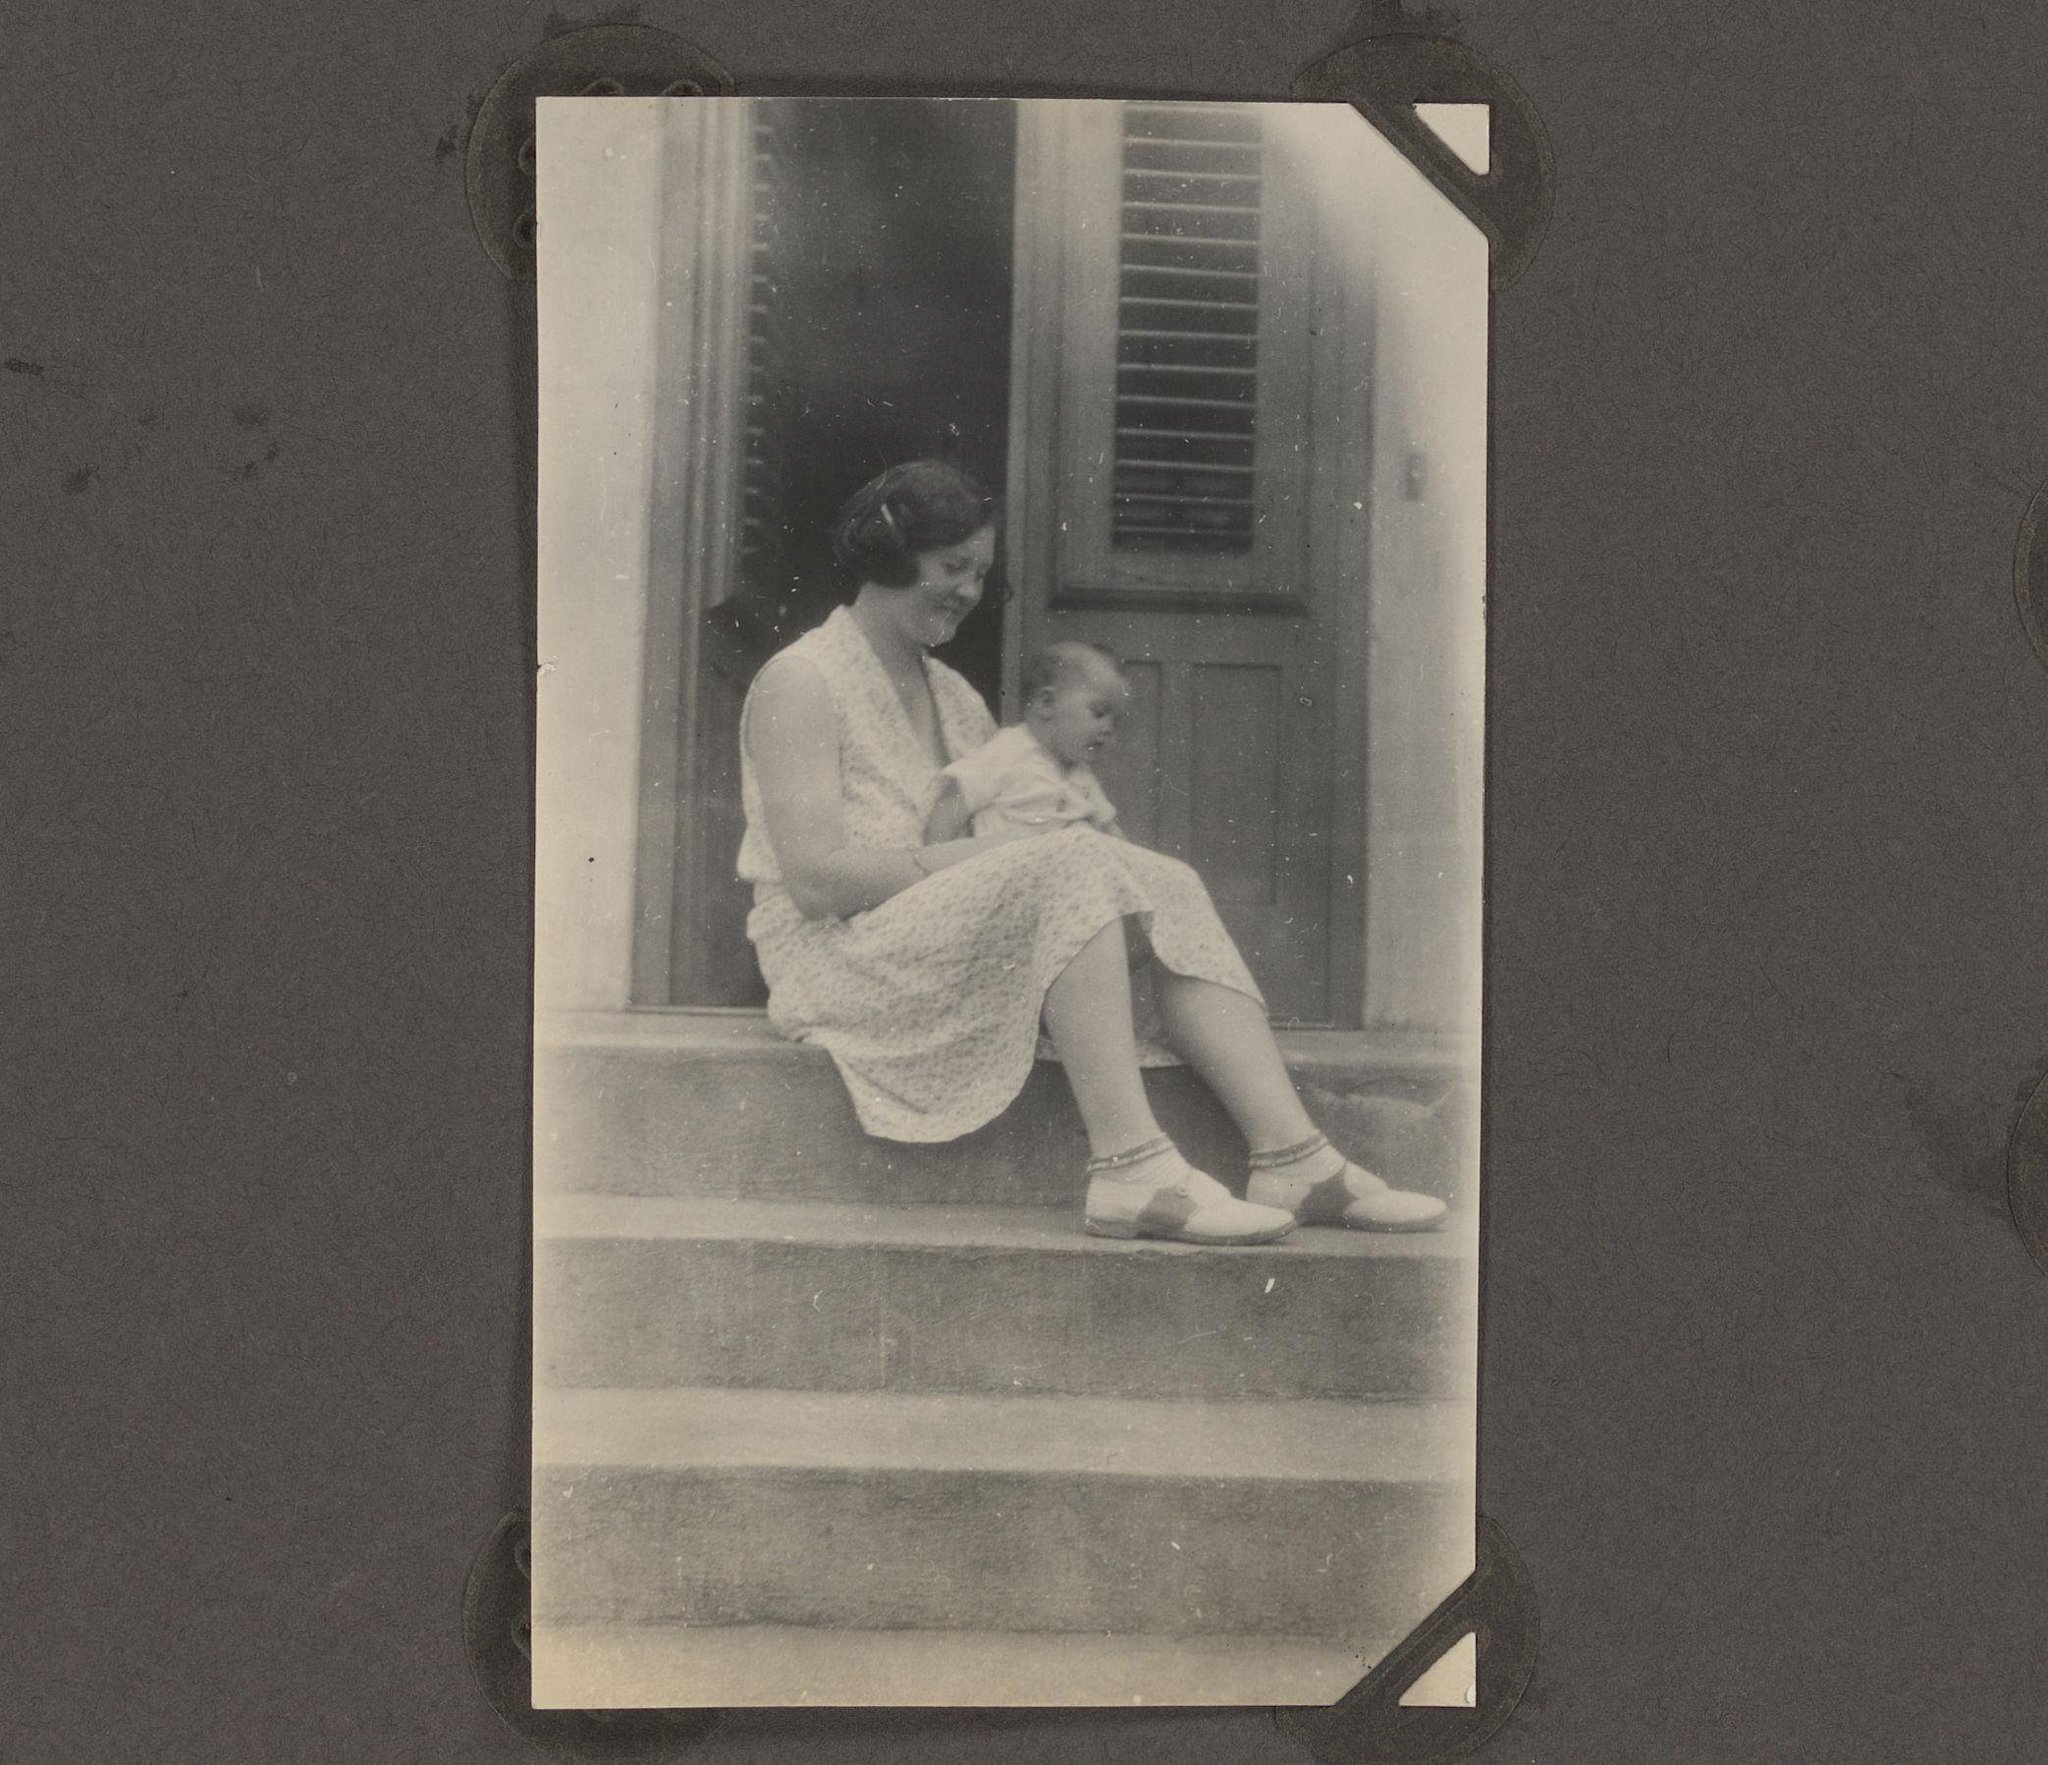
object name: photograph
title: Familiefoto van de kinderen Jetten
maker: Anonymous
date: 1925-1927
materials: photographic support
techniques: photography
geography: suriname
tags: jetten, familie, moengo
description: Familiefoto van de kinderen Jetten met hun moeder. Foto op een bladzijde van een los albumblad. Onderdeel van het ensemble met foto's van de familie van ingenieur Jetten in de mijnbouwstad Moengo in Suriname.